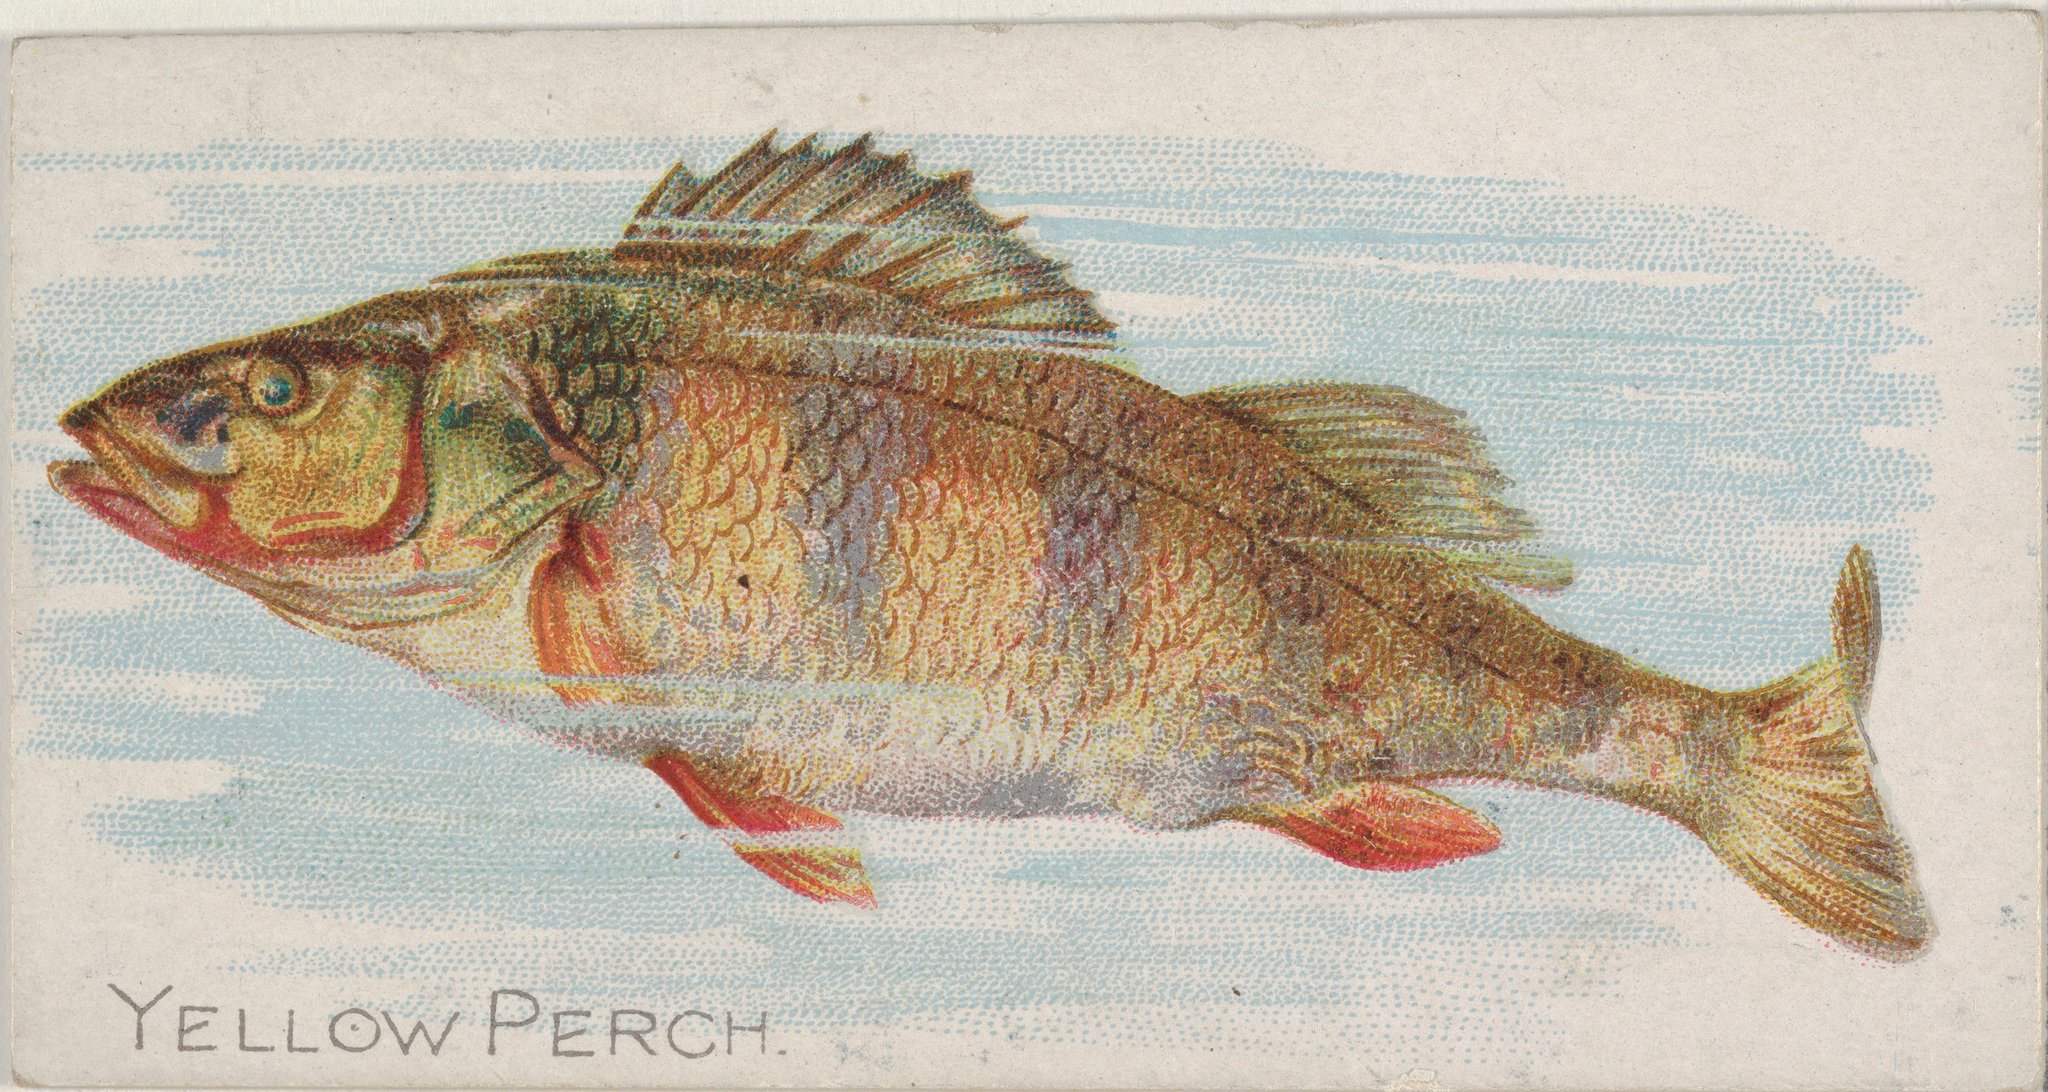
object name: print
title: Yellow Perch, from the Fish from American Waters series (N8) for Allen & Ginter Cigarettes Brands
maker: allen & ginter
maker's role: publisher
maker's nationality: american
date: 1889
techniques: color lithograph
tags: fish